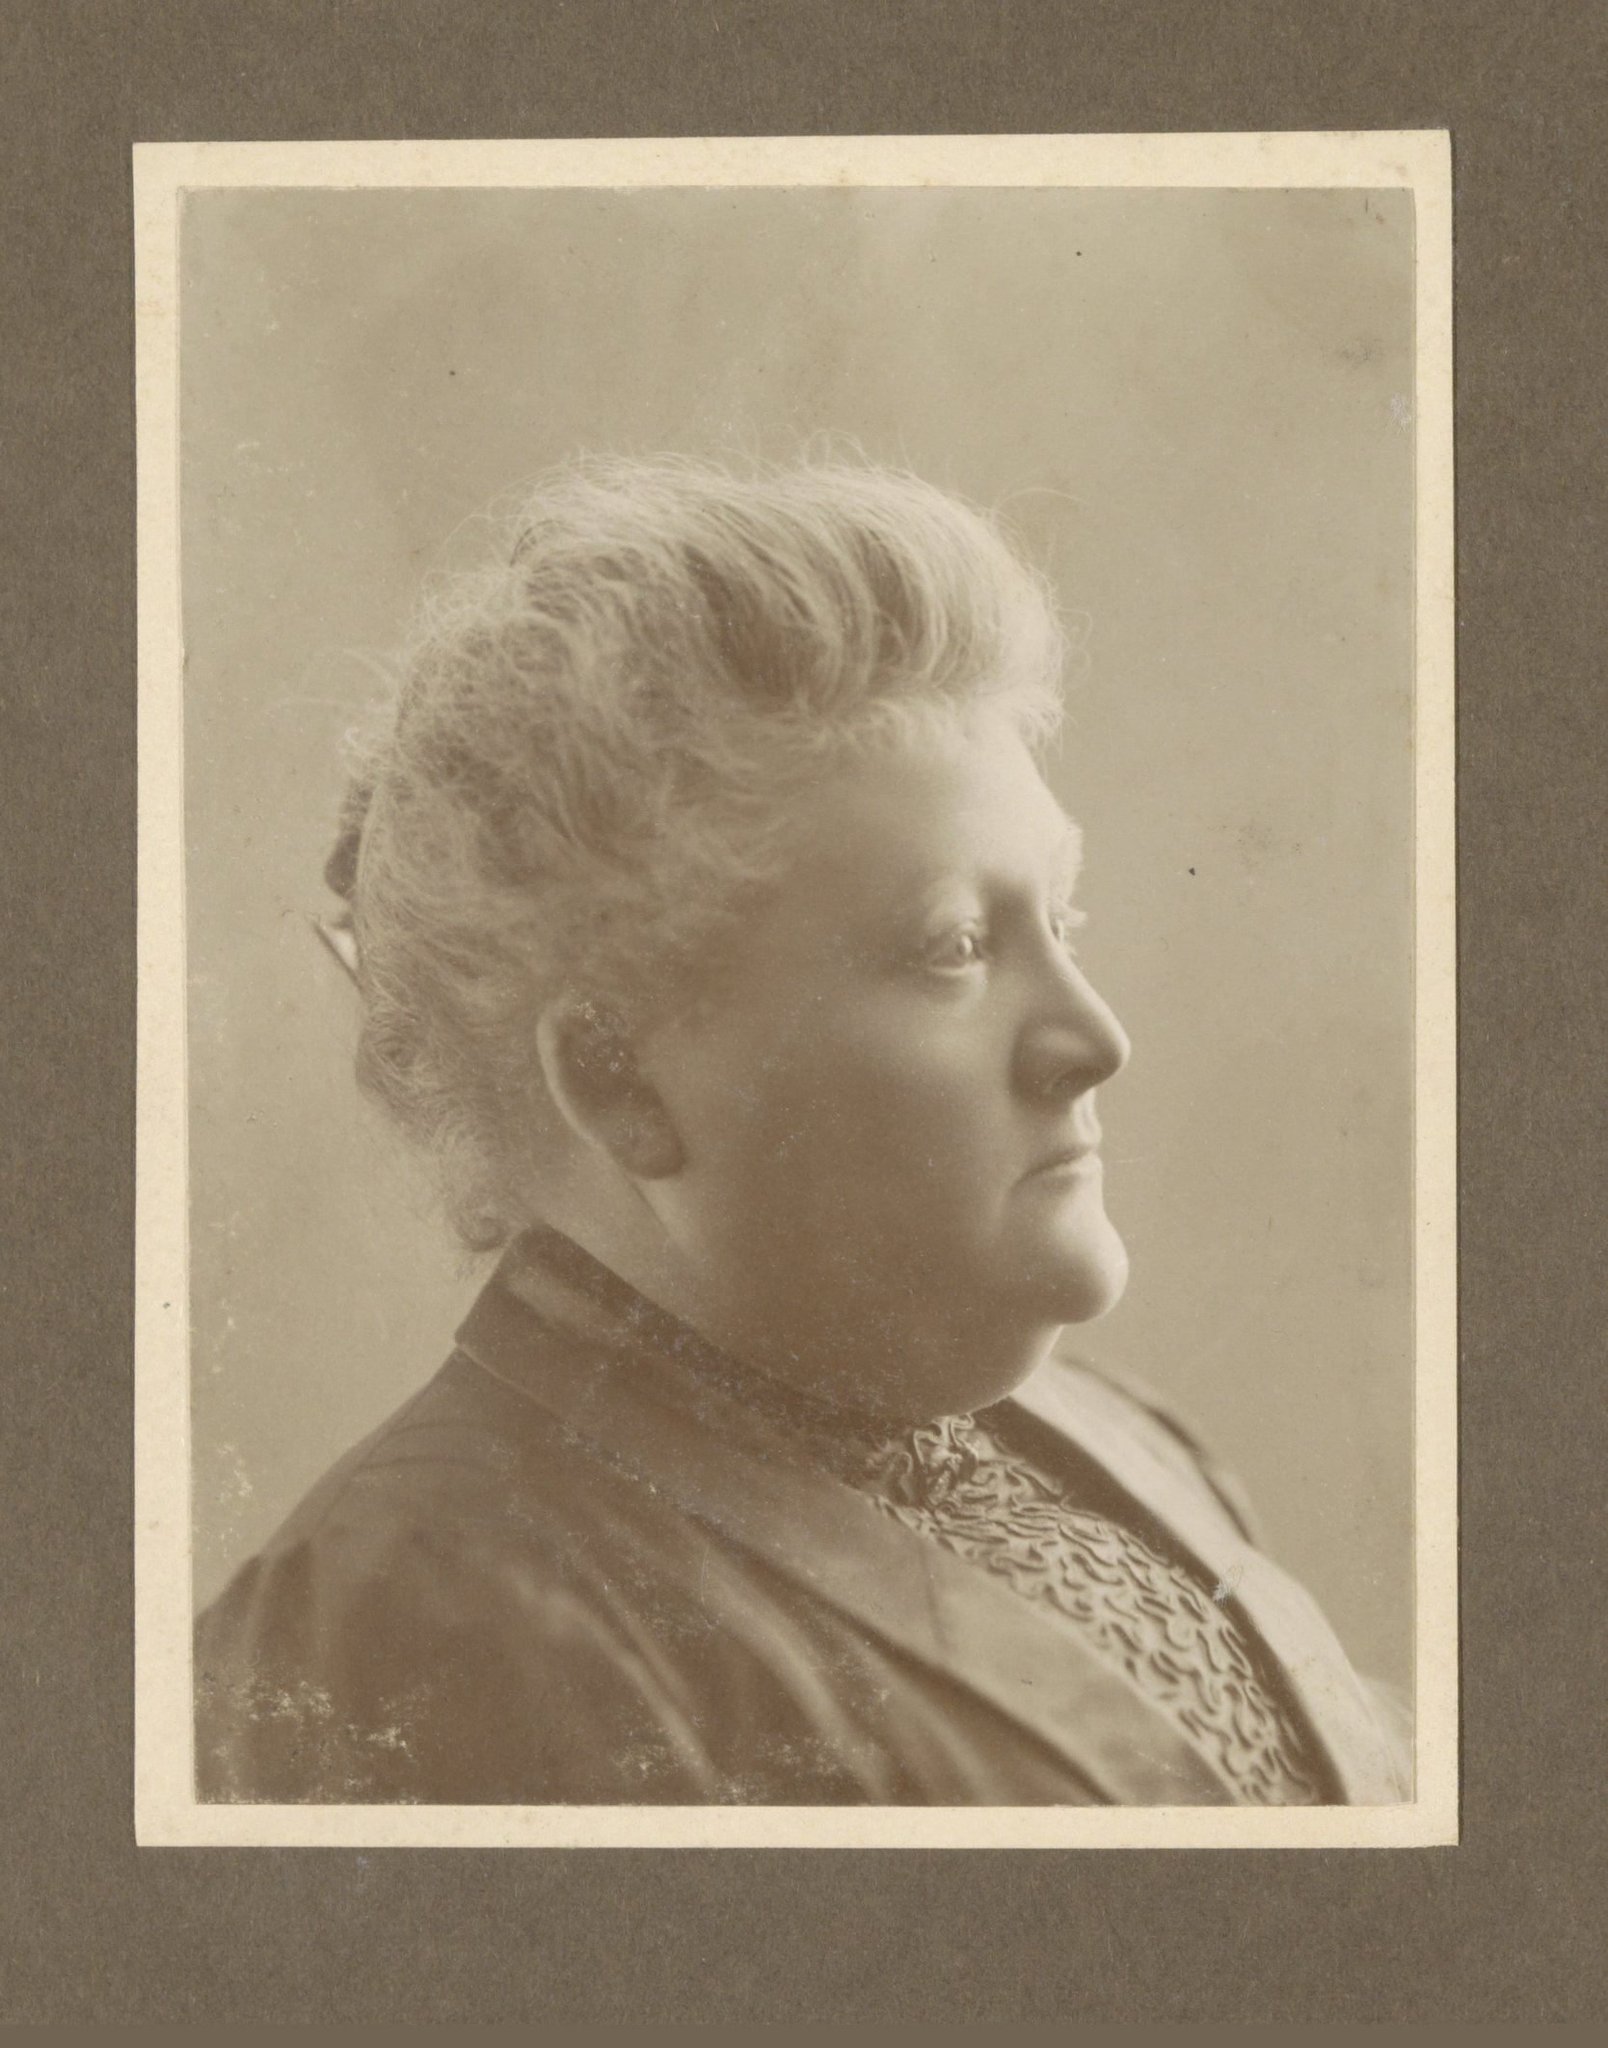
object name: photograph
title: Portret van G. Vermeulen-Luitjes, en profil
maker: cornelis johannes lodewicus vermeulen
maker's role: fotograaf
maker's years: 1861-1936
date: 1900-1920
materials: paper, photographic support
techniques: gelatin silver print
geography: the hague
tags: adult woman, the hague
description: Onderdeel van Fotoalbum met opnames van het gezin en het huis van fotograaf C.J.L. Vermeulen in Den Haag.